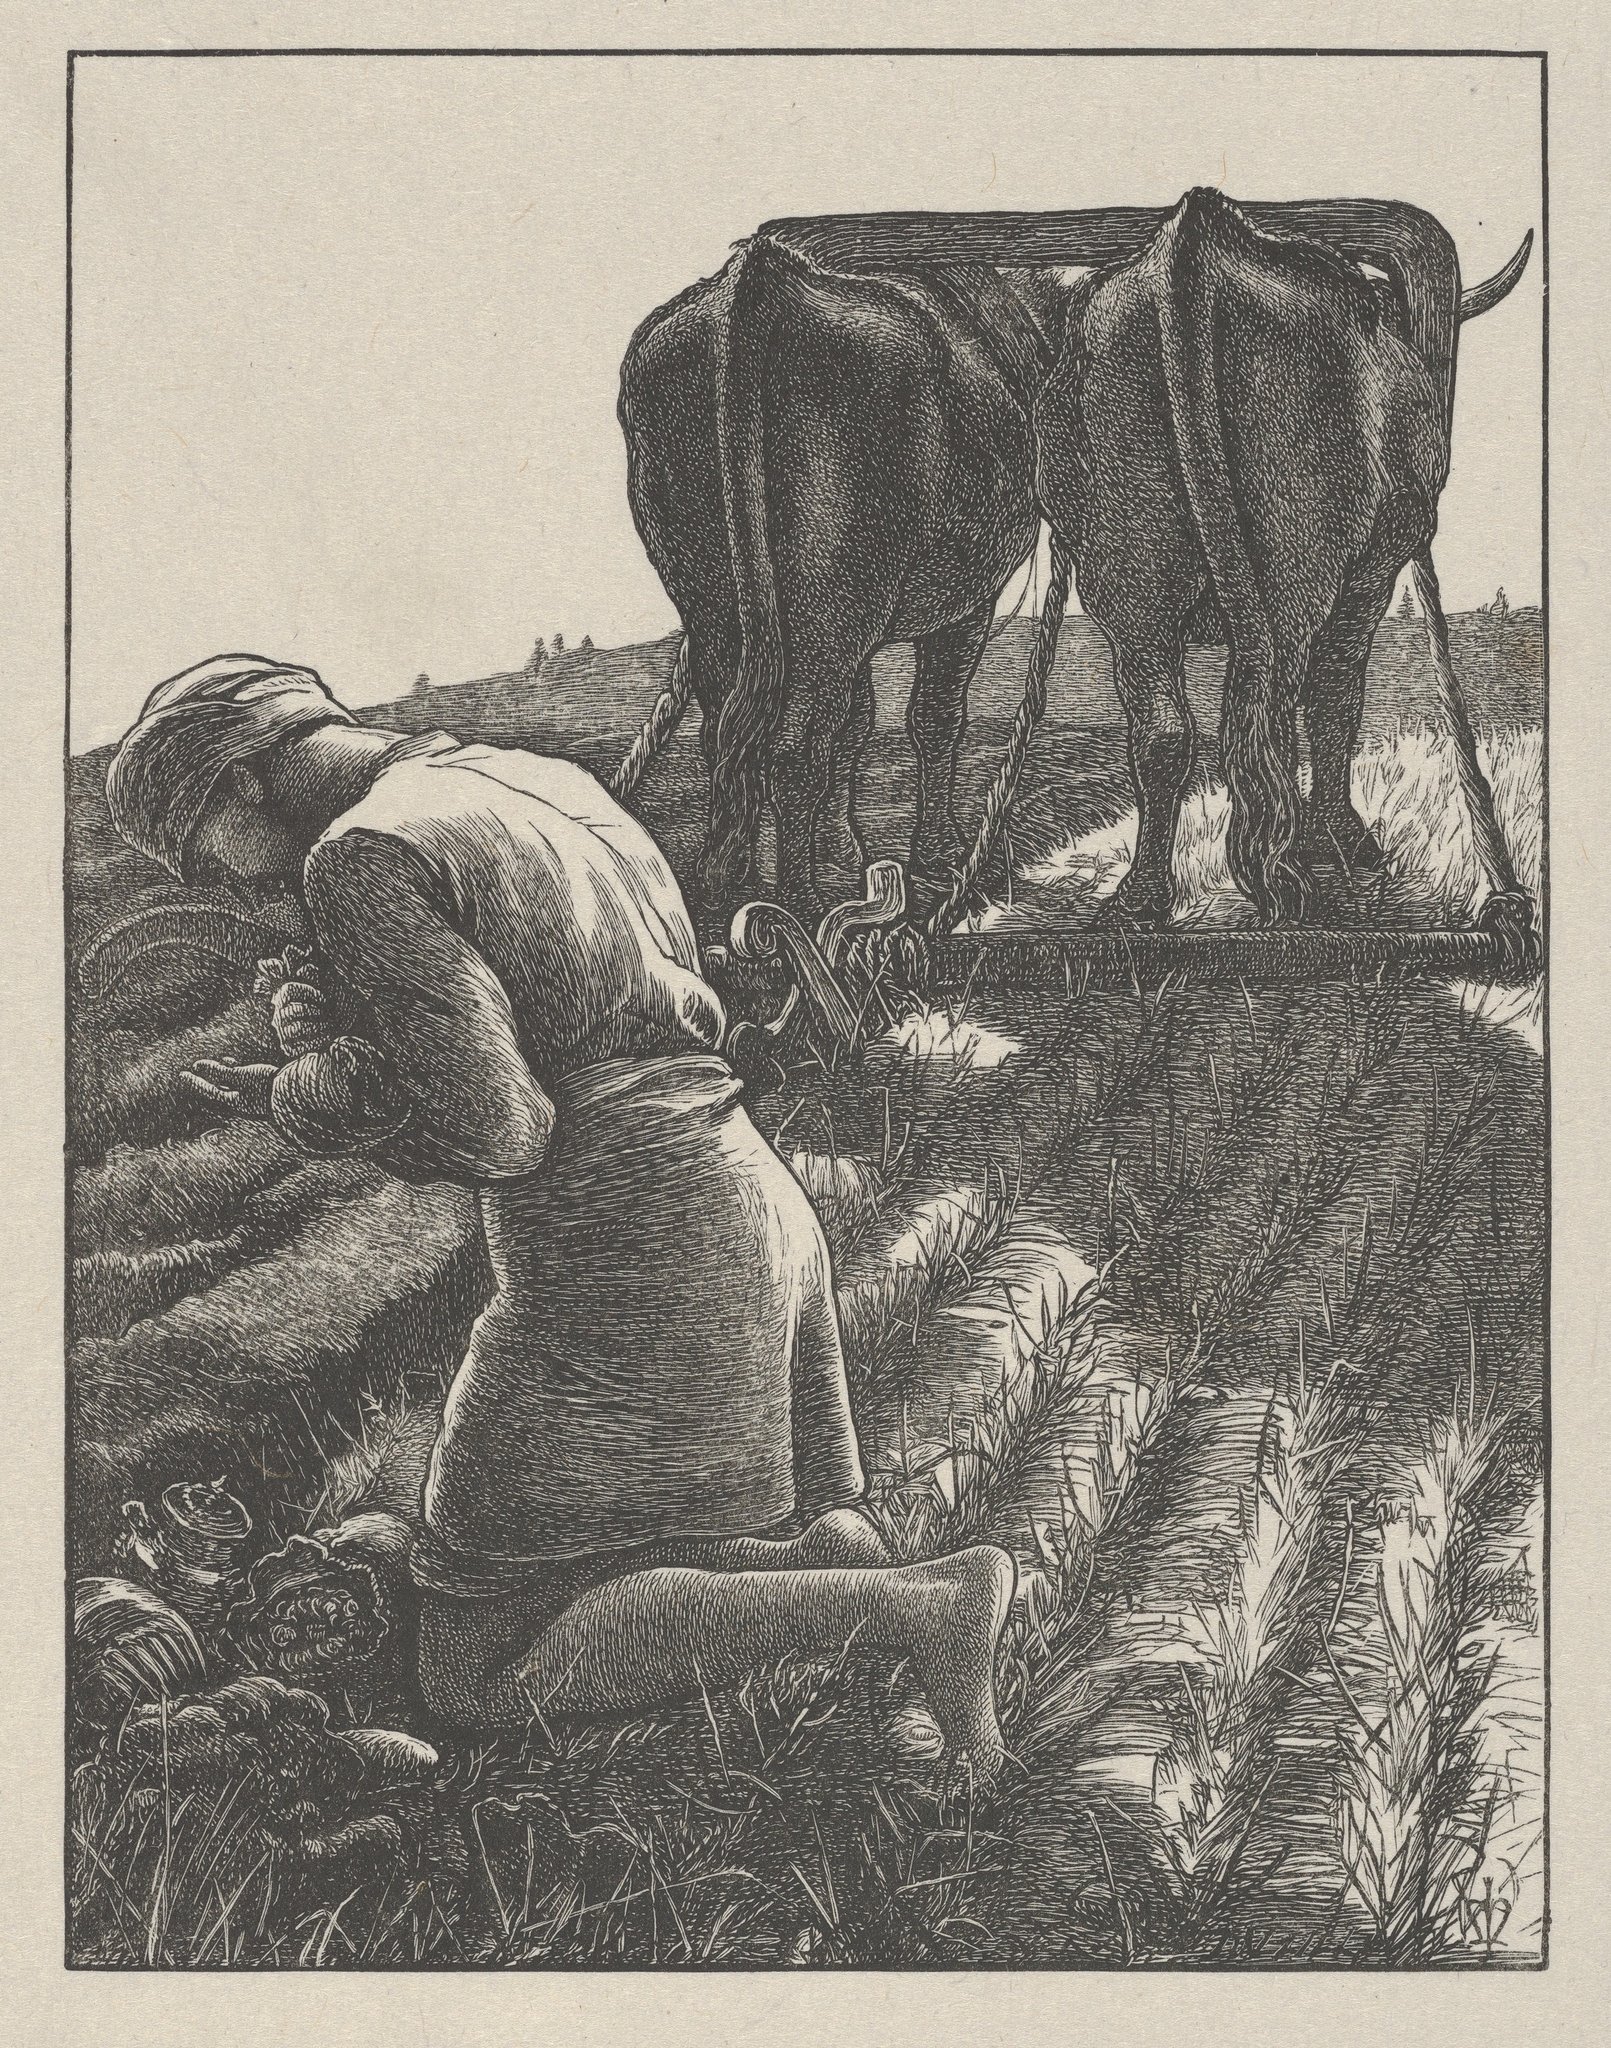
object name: print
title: The Hidden Treasure (The Parables of Our Lord and Saviour Jesus Christ)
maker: sir john everett millais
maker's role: artist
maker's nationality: british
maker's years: 1829-1896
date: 1864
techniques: engraving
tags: animals,men,agriculture,farmers